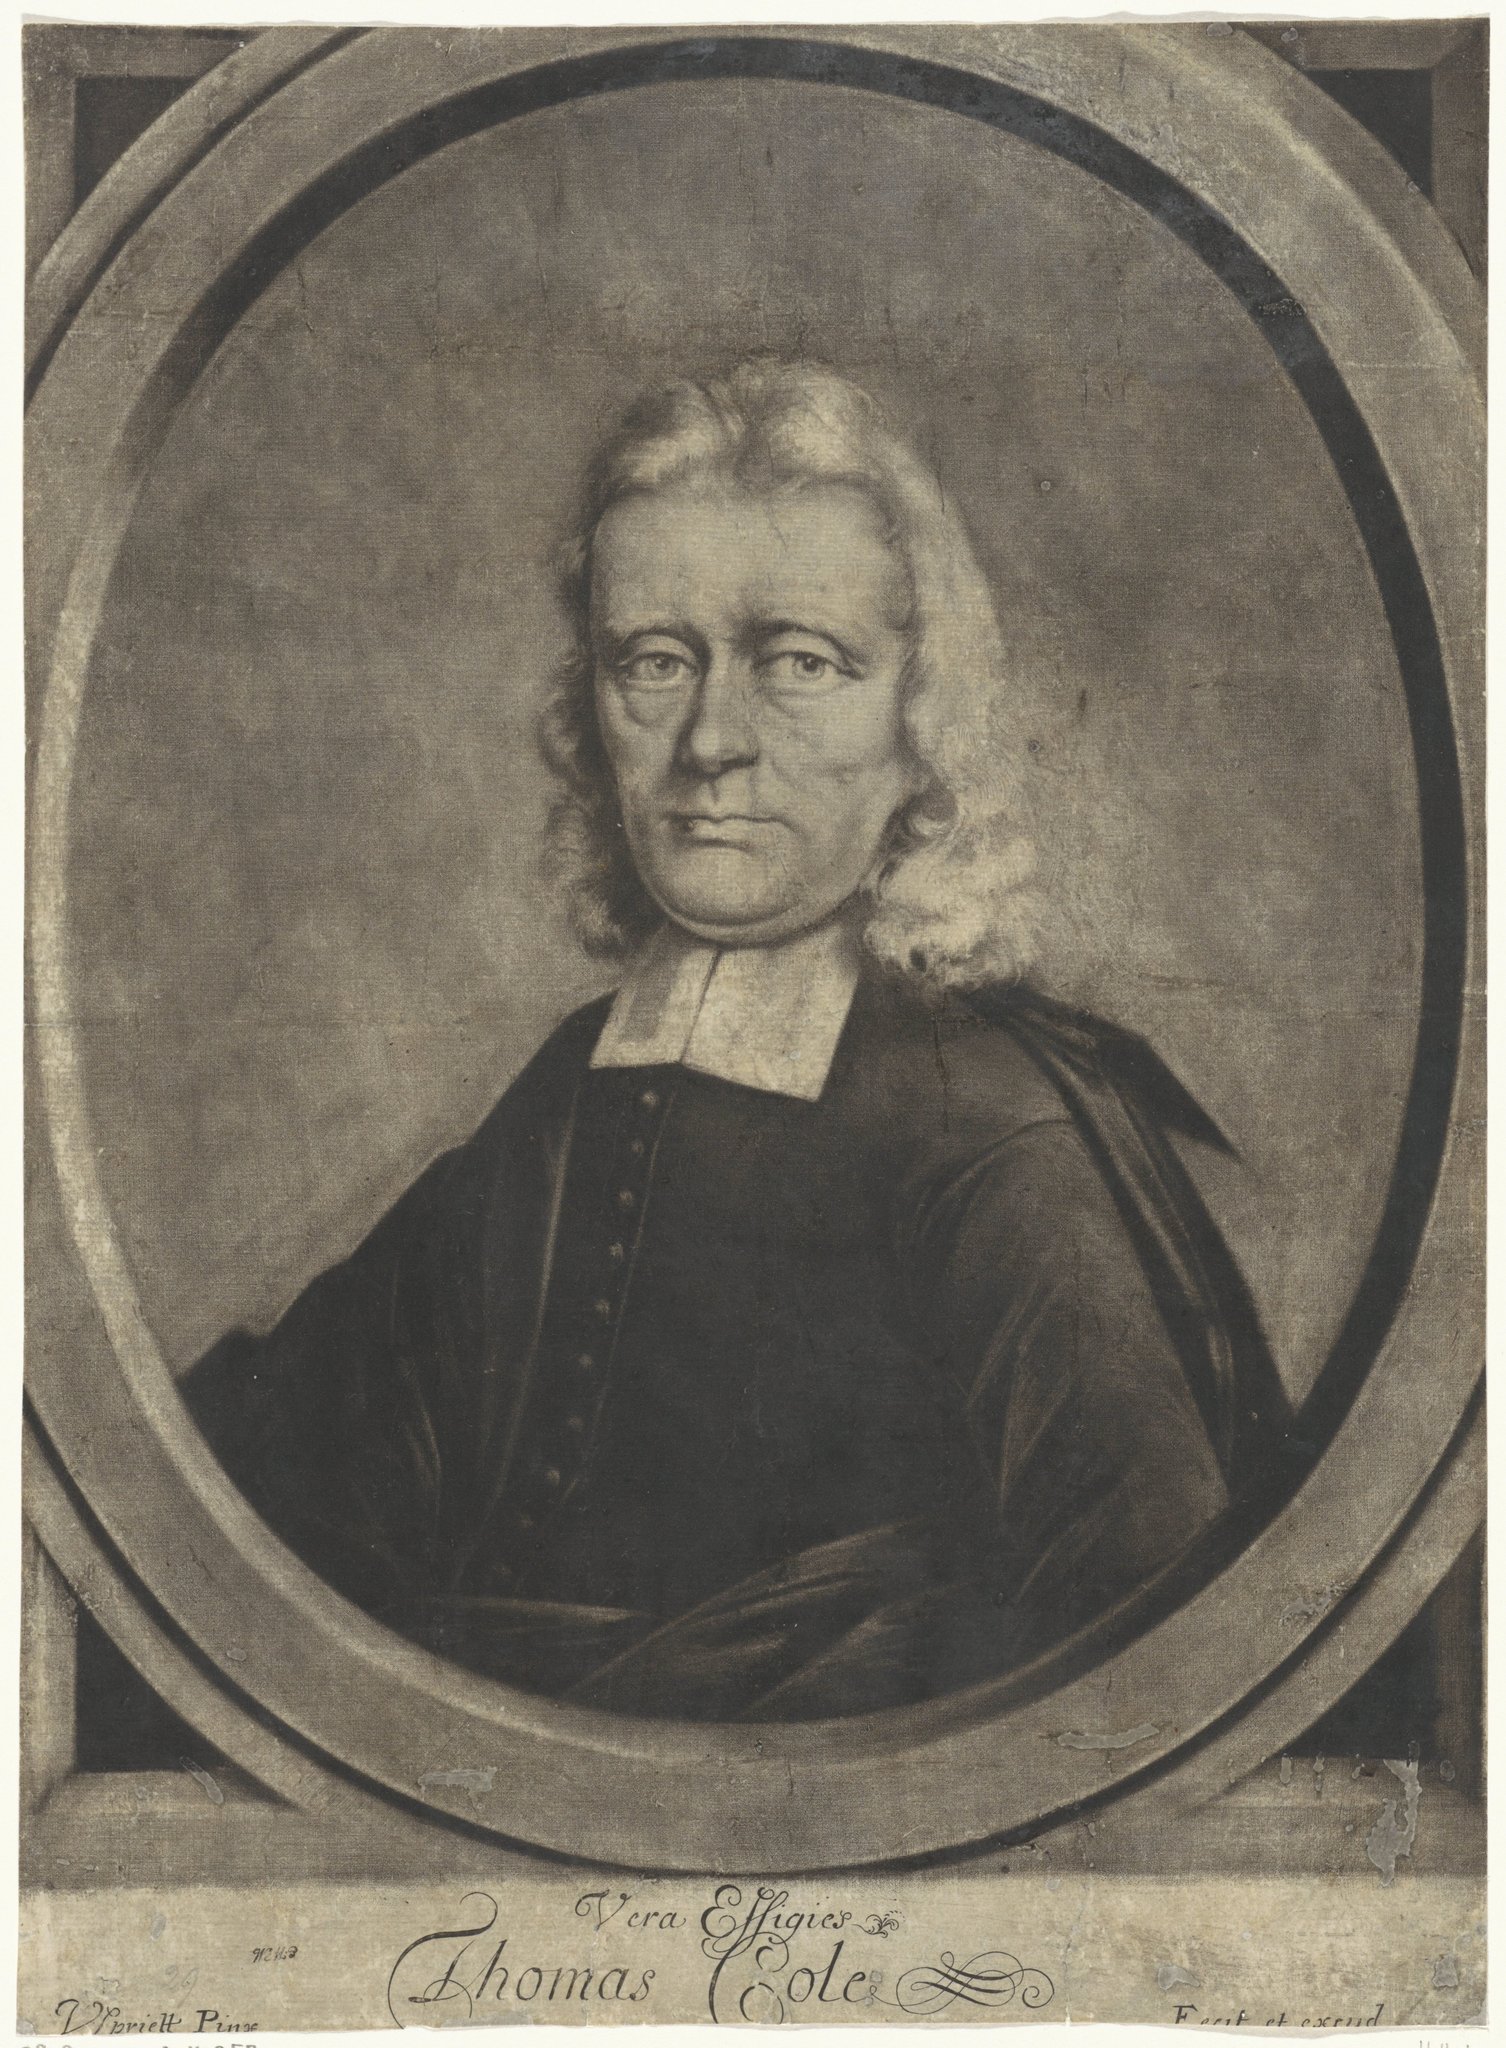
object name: print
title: Portret van Thomas Cole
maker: jan van der spriet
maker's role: print maker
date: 1675-1690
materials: paper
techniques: mezzotint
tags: thomas cole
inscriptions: collector's mark: Lugt 2228